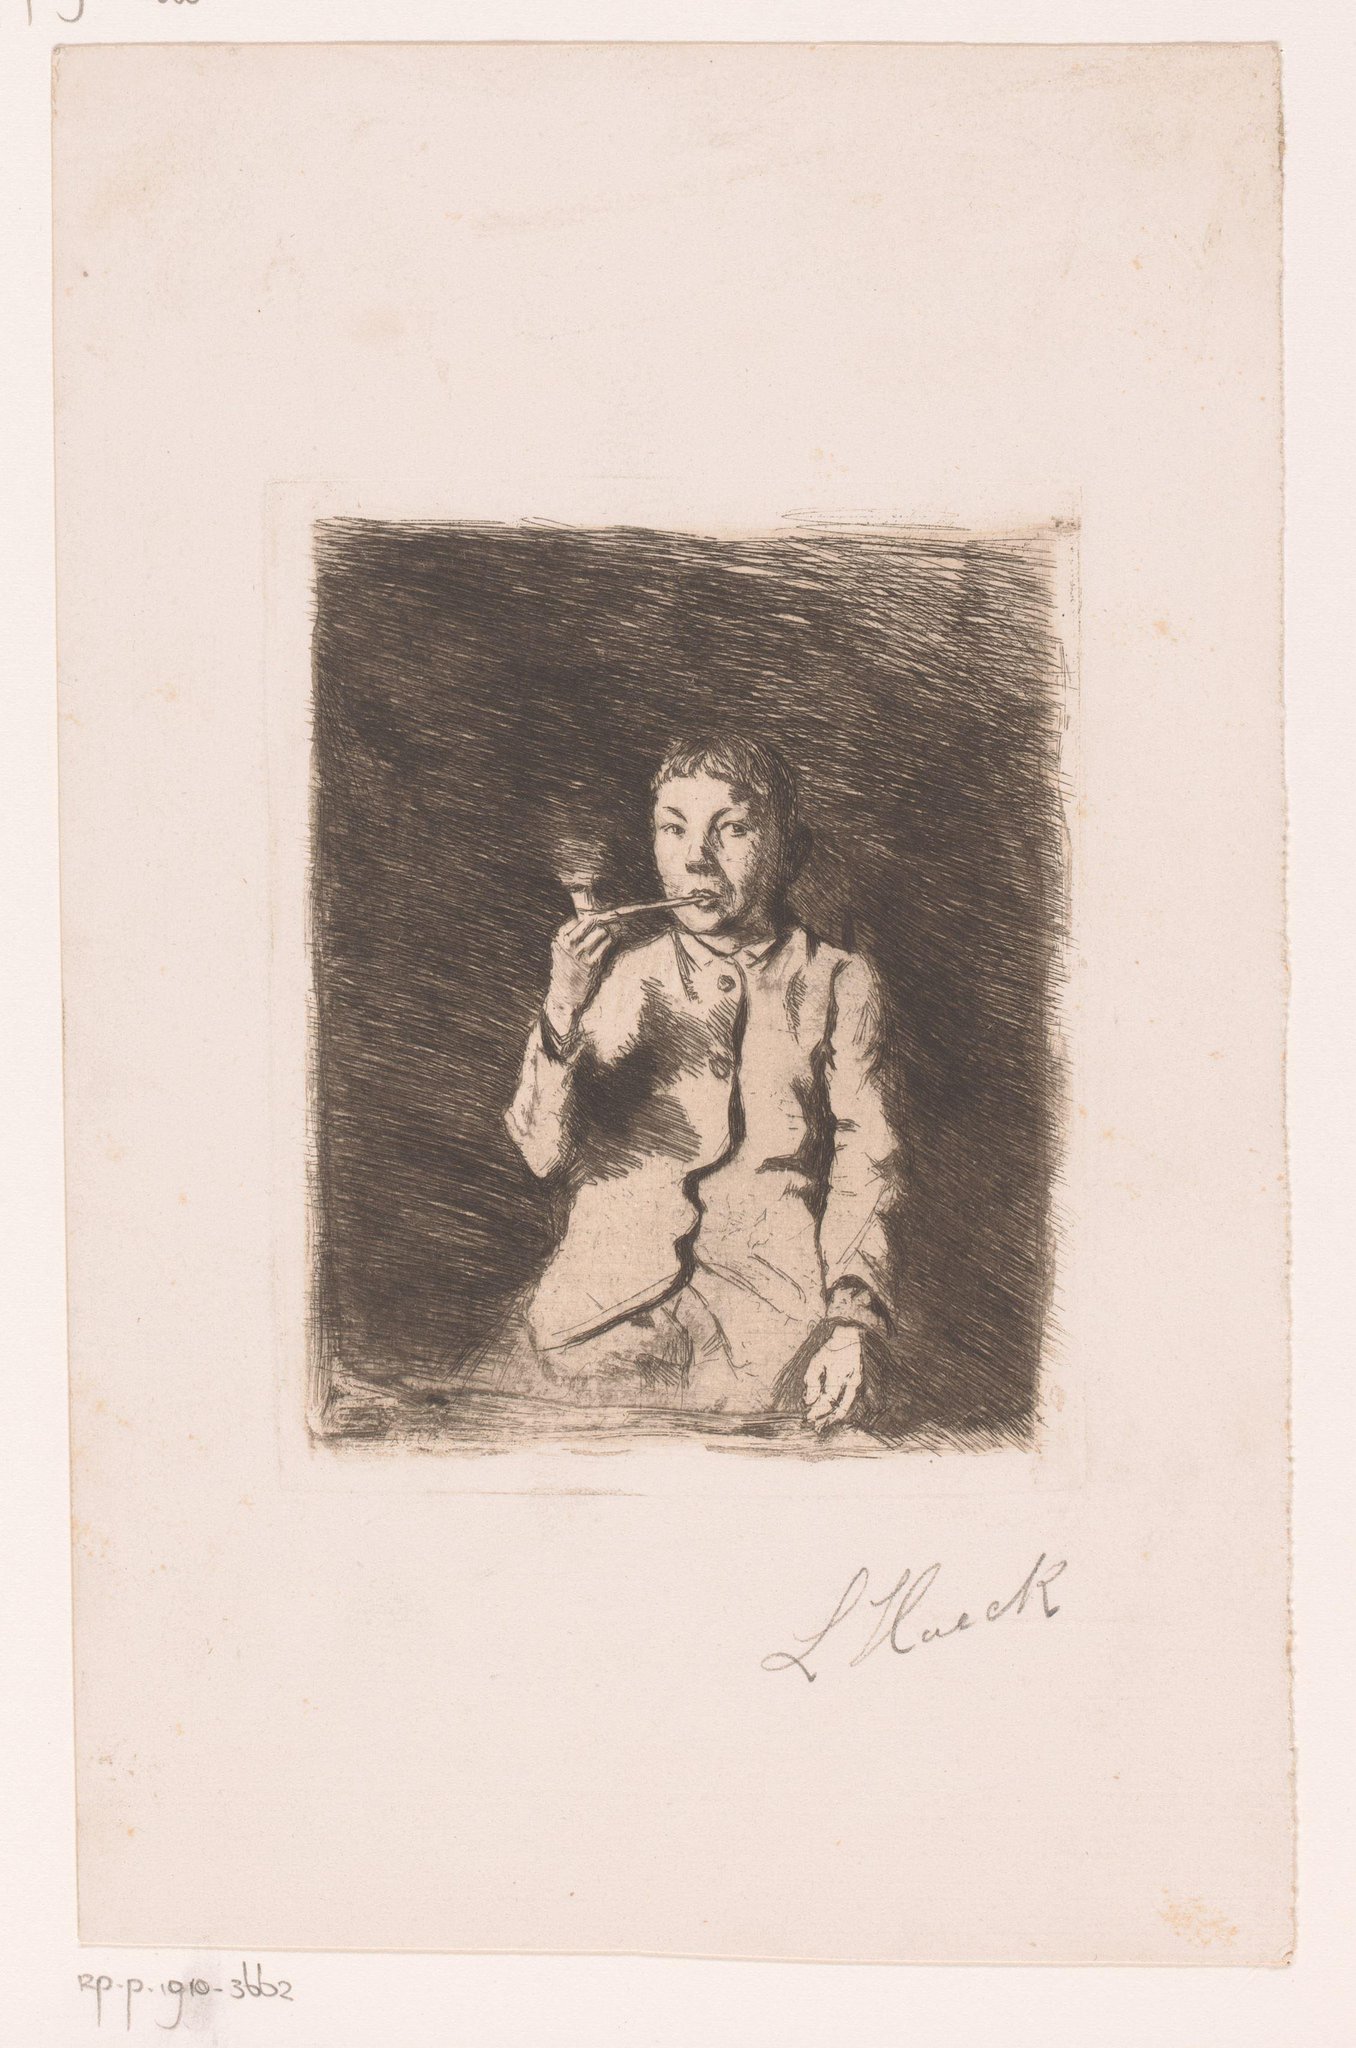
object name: print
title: Jongeman rookt een pijp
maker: léopold haeck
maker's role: painter, print maker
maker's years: 1868-1928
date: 1878-1910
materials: paper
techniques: etching, intaglio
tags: pipe ~ tobacco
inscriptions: collector's mark: Lugt 2228